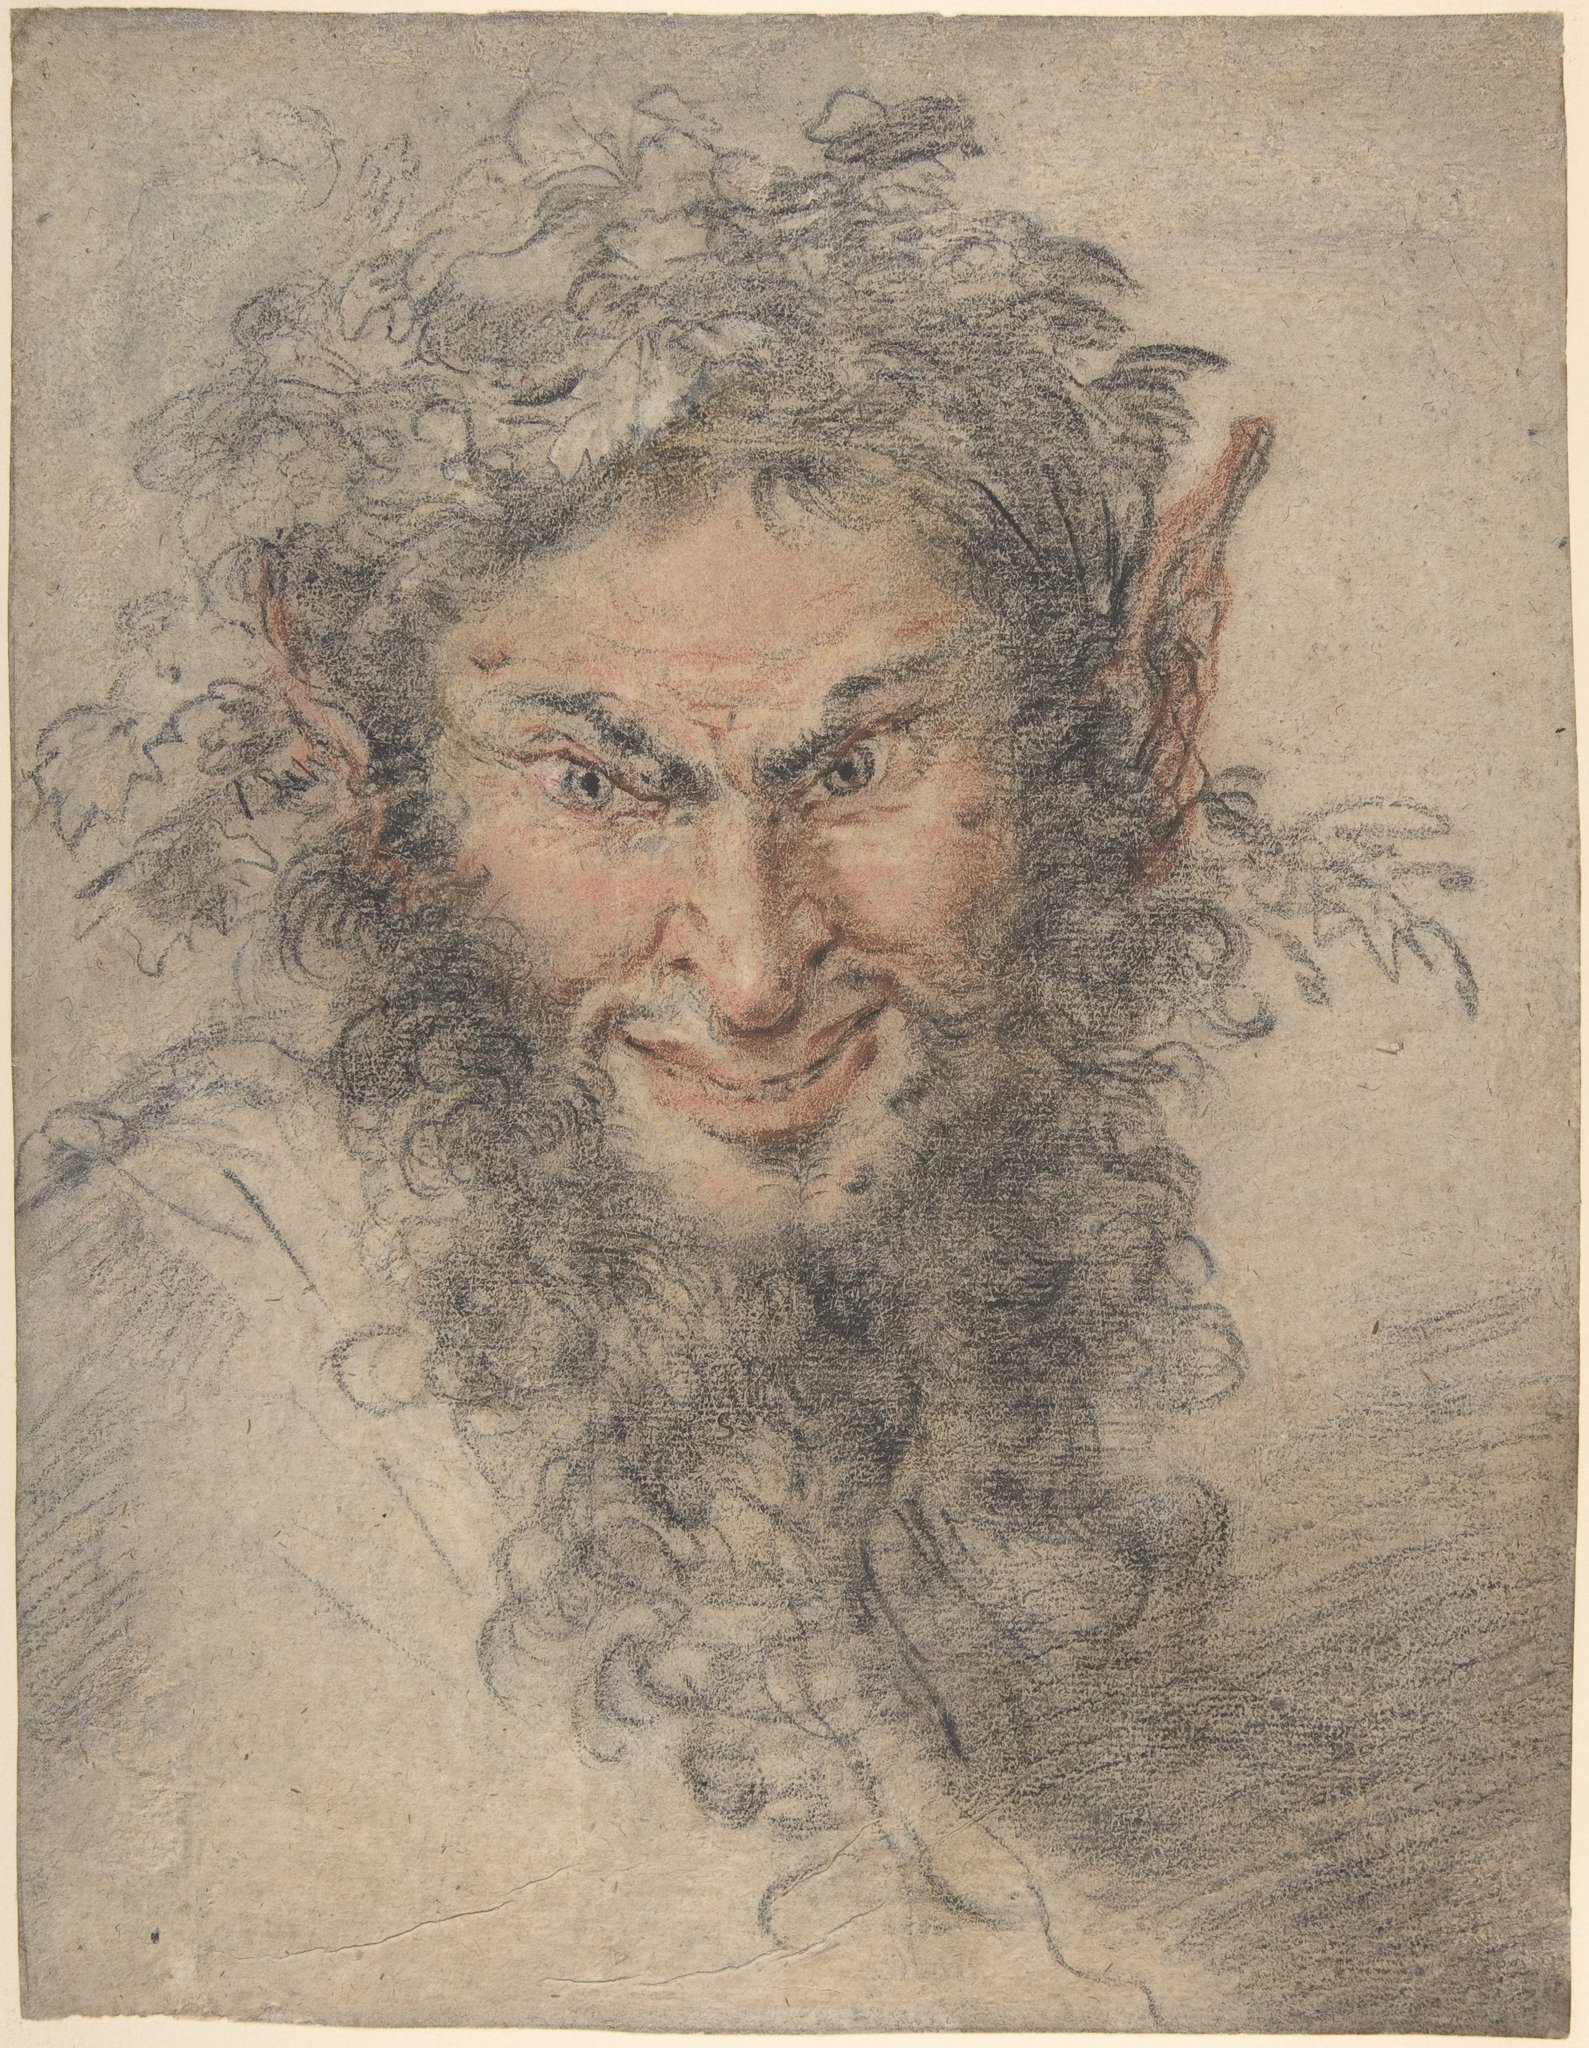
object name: drawing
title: Head of a Satyr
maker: antoine watteau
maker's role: artist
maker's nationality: french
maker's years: 1684-1721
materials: chalk, paper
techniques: heightening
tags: satyrs